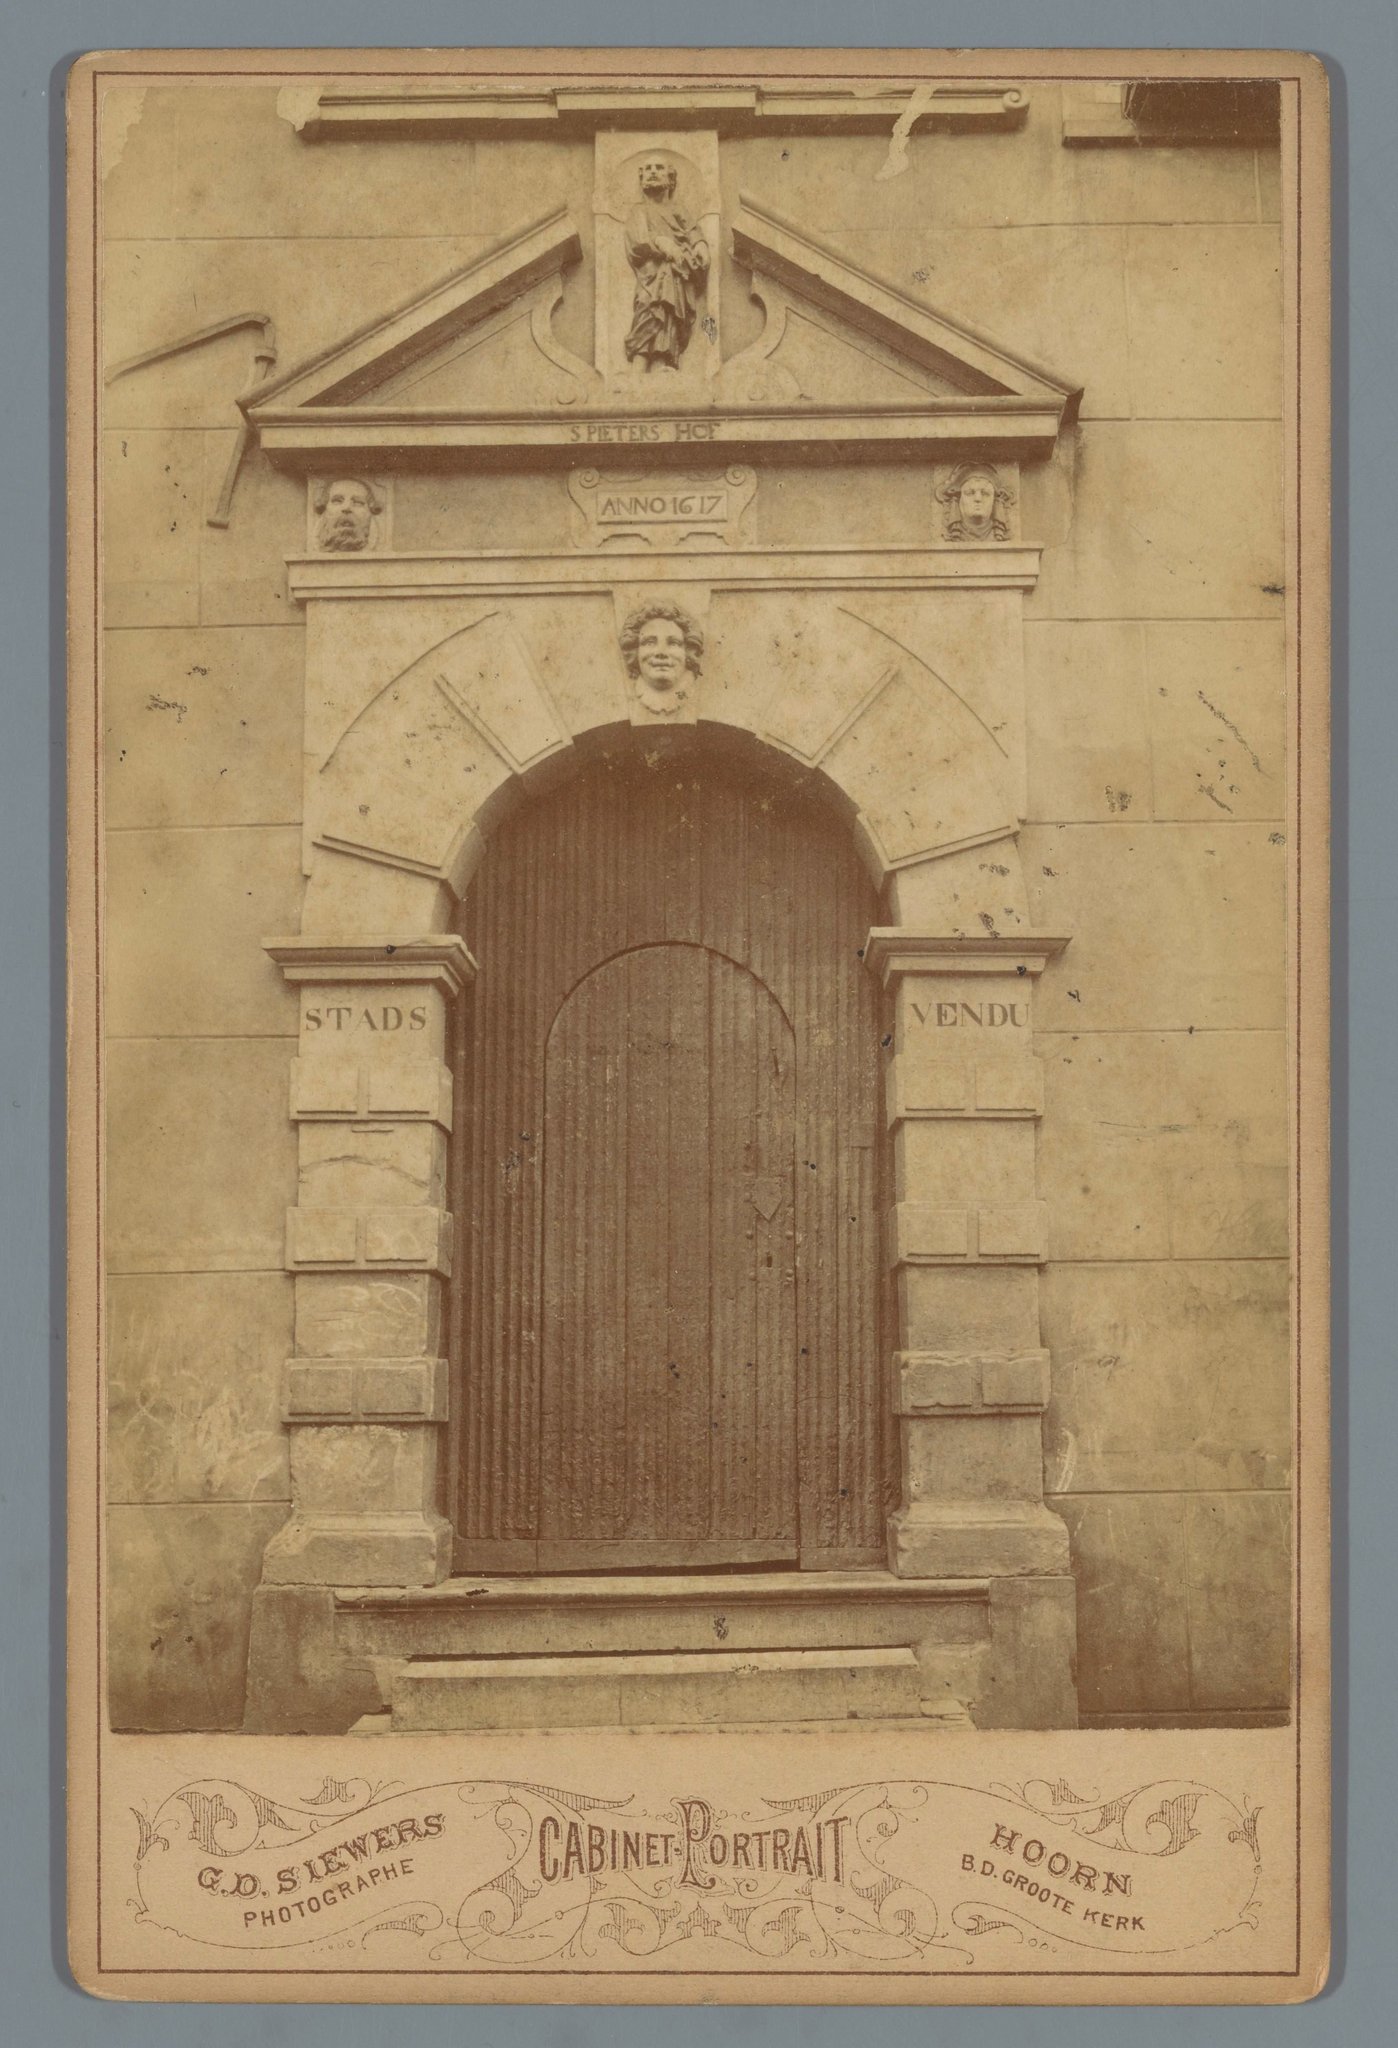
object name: photograph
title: Poort in de oostelijke vleugel van het Sint-Pietershof te Hoorn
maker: gerrit dirk siewers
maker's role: fotograaf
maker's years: 1846-1899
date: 1850-1900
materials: cardboard, photographic support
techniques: albumen print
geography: hoorn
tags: gate, entrance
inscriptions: name: ‘G.D. SIWERS PHOTOGRAPHE/ CABINET PORTRAIT/ HOORN B.D. GROOTE KERK’, inscription: ‘De raamsteeg/ thans Spoorstraat Hoorn/ tegenover het Munnickenveld/ Munnickenveld/’